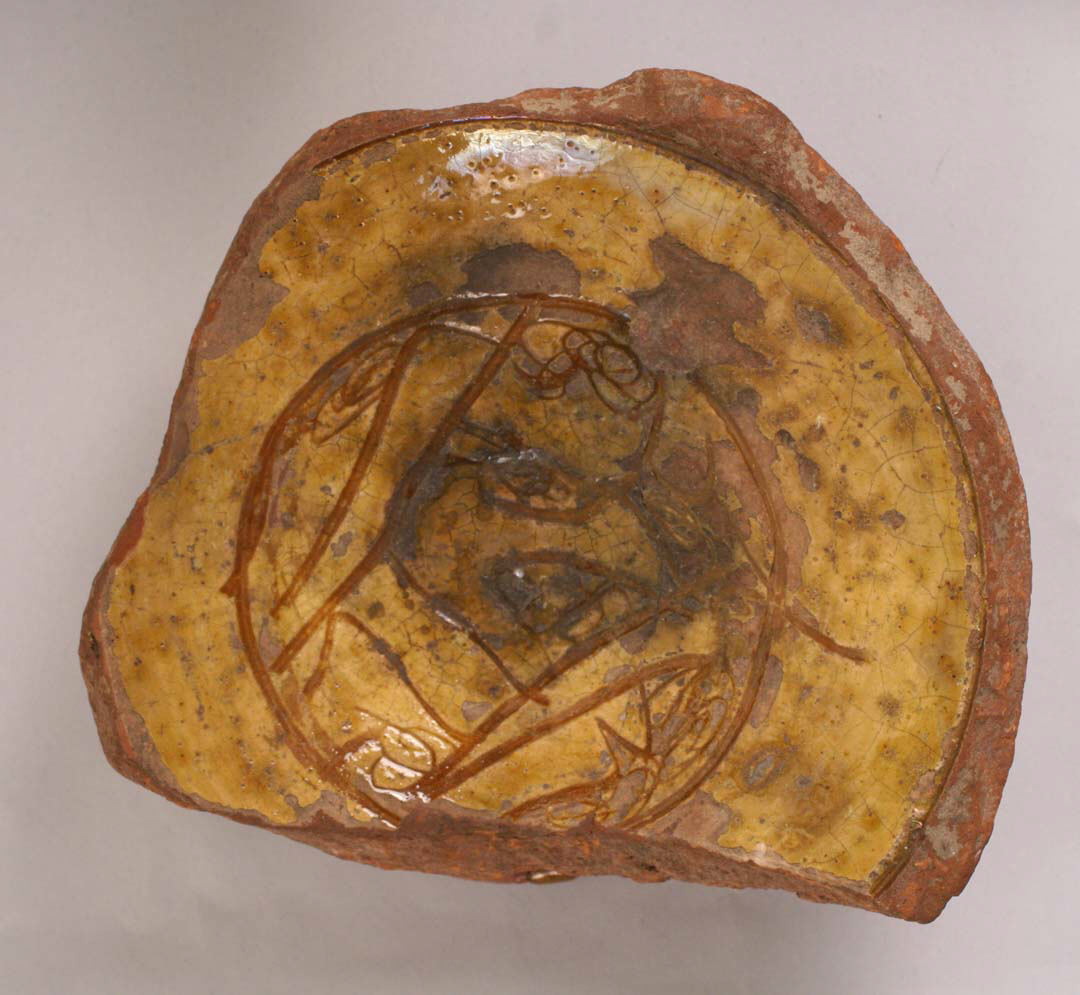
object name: fragment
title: Fragment of a Bowl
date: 1301-1500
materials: earthenware, glaze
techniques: coloring, incising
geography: egypt